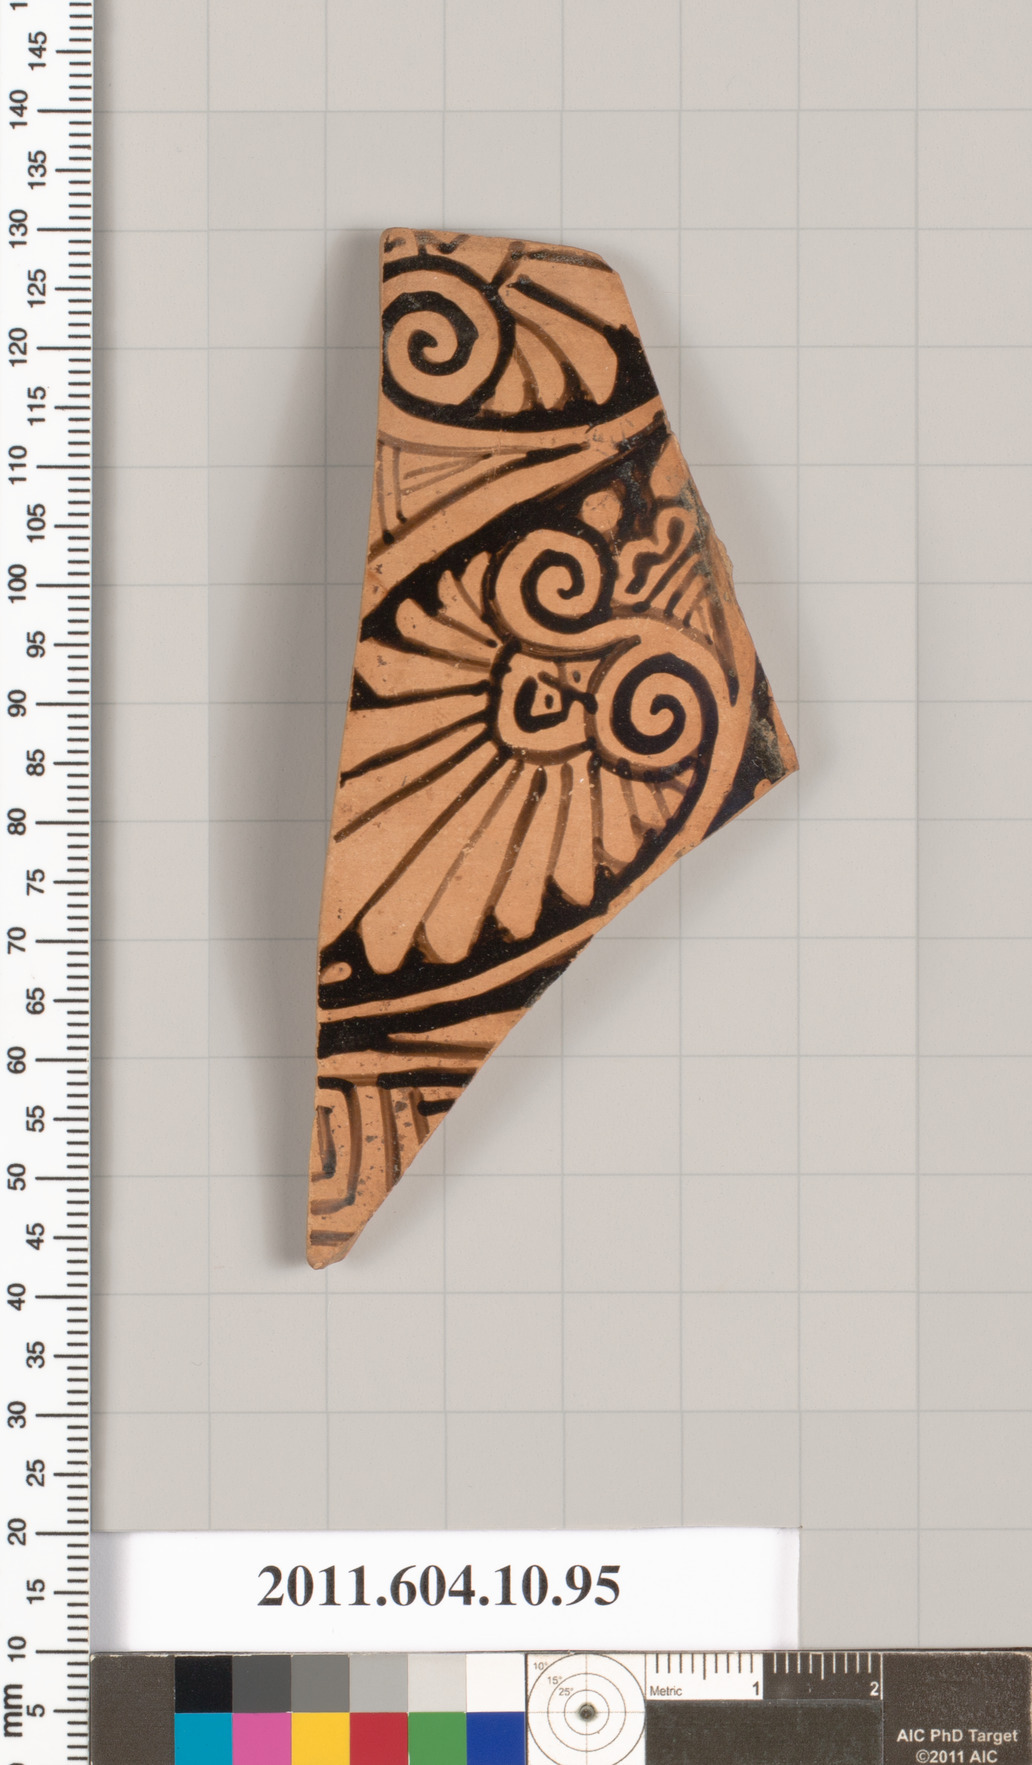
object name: undetermined closed shape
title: Terracotta fragment of a closed shape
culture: etruscan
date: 400-301 BCE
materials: terracotta